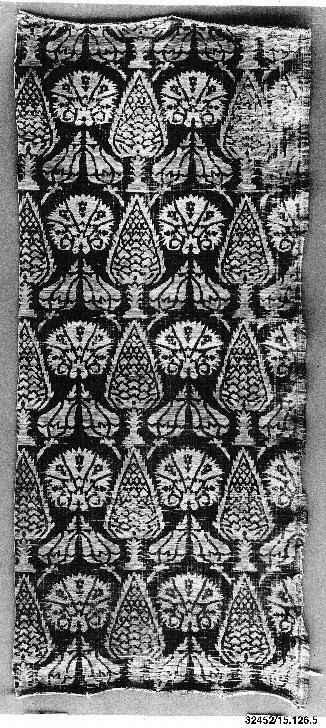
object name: textile fragment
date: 1601-1700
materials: velvet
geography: turkey